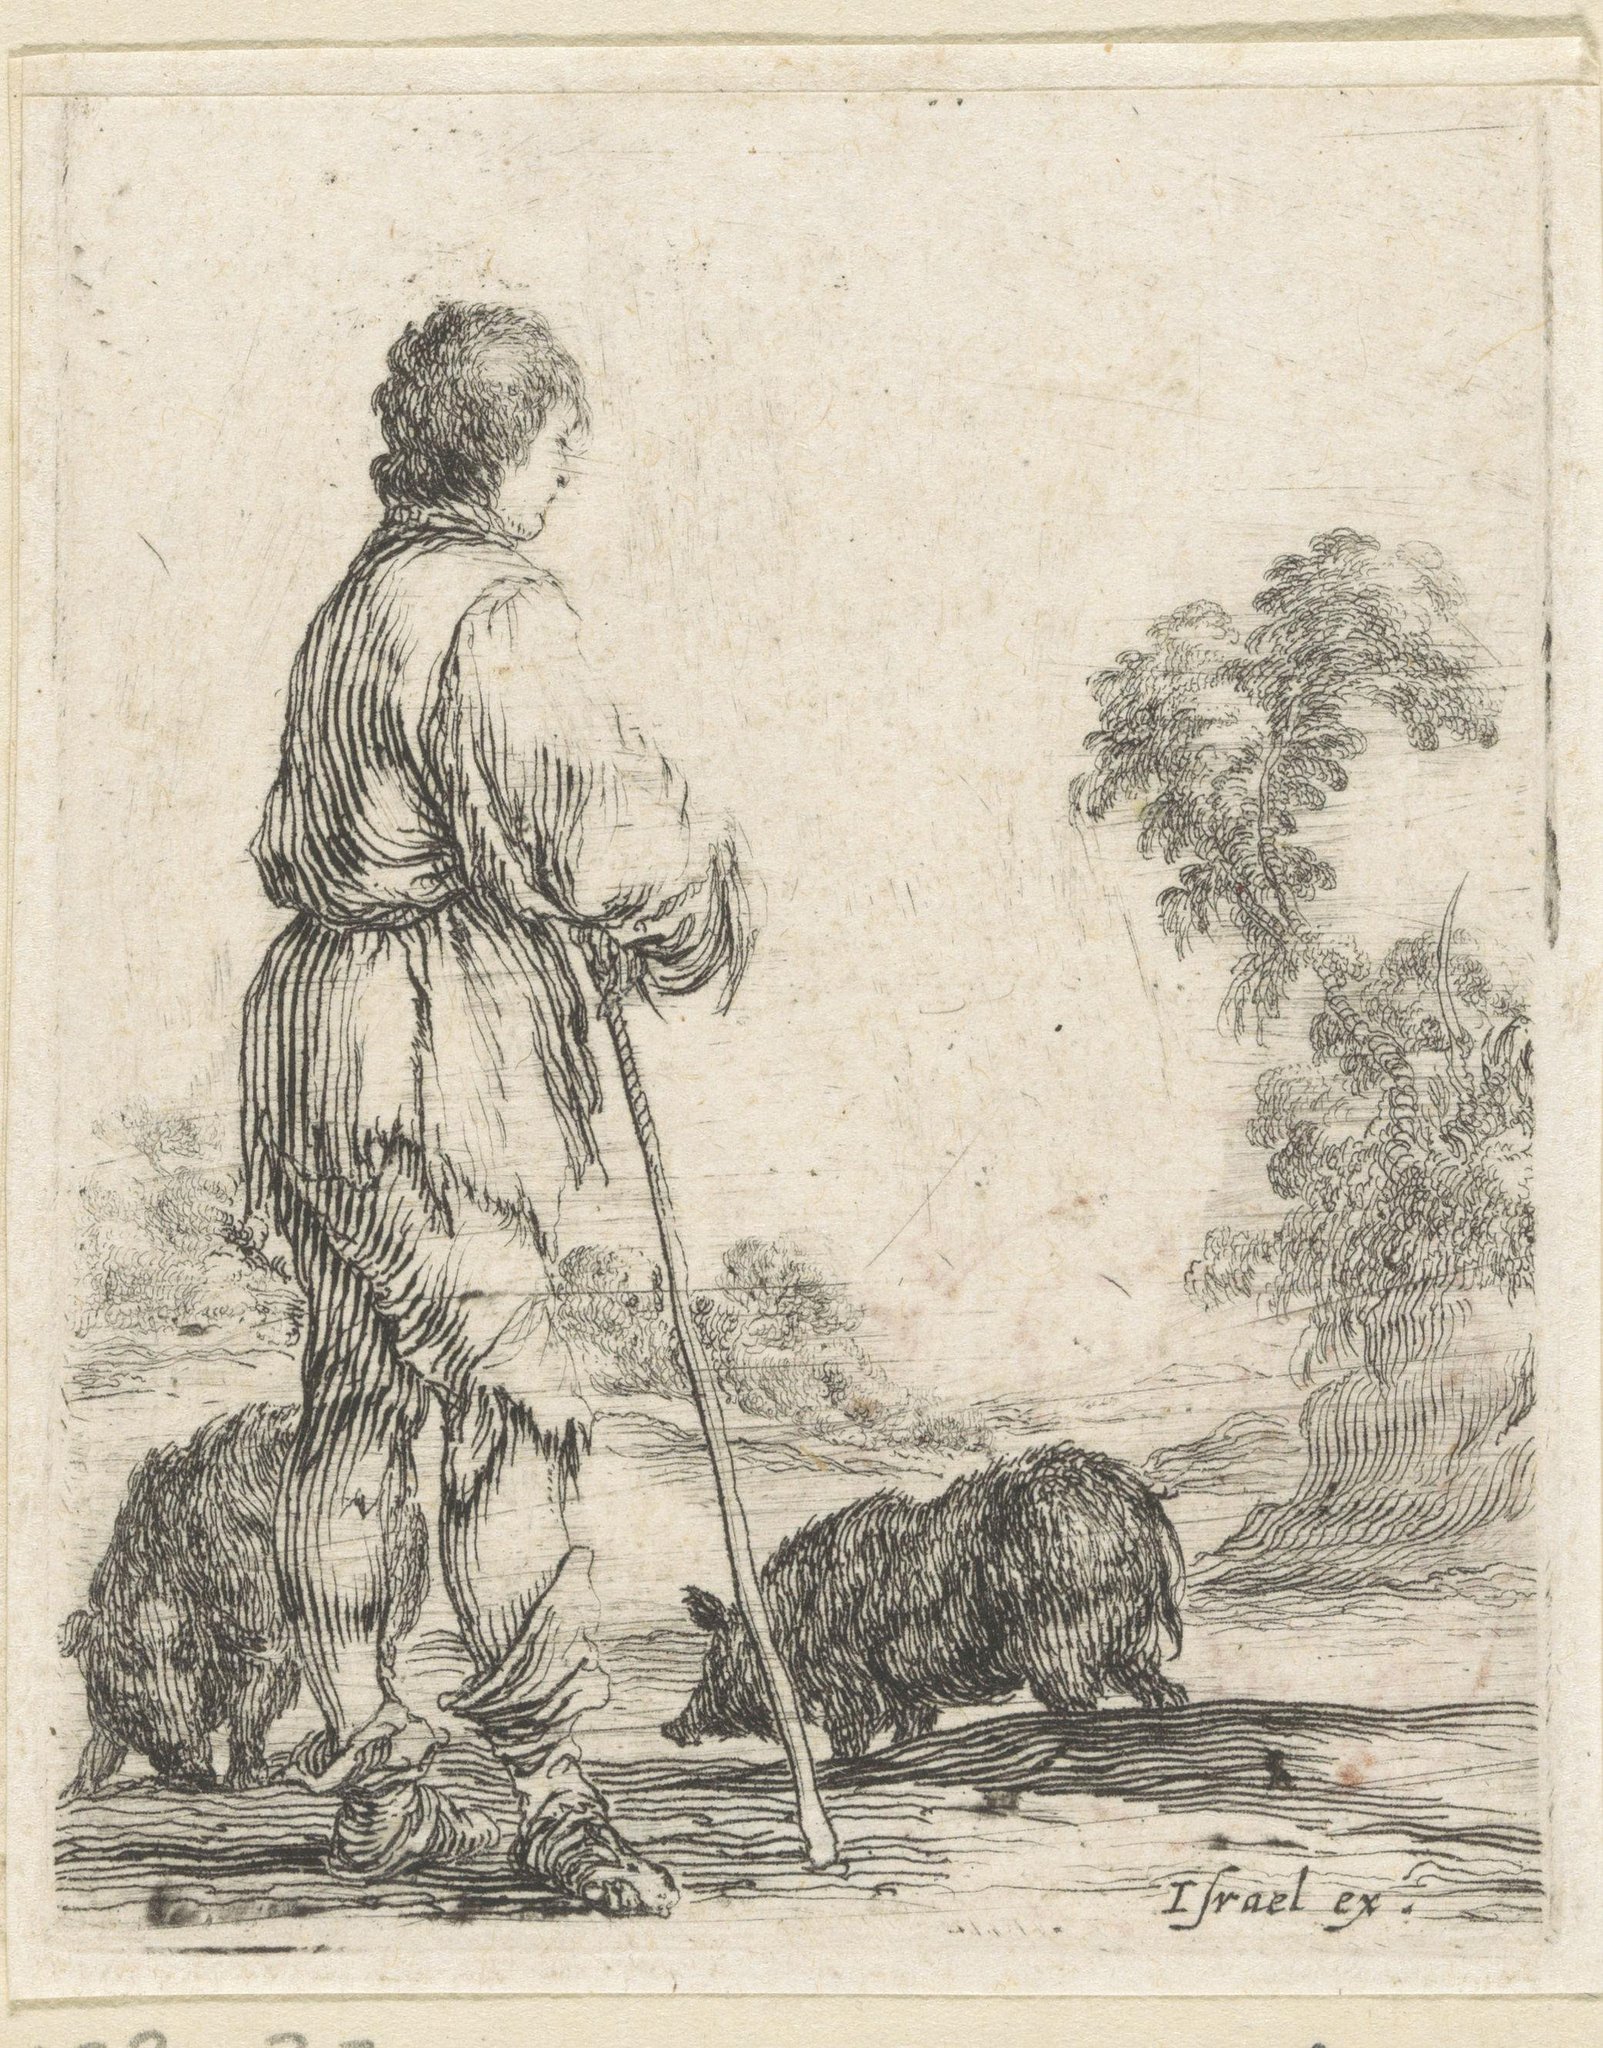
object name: print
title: Verloren Zoon de varkens hoedend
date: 1620-1664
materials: paper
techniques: etching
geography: paris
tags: the parable of the prodigal son (luke 15:11-32)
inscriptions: collector's mark: Lugt 240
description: Een jongeman, de Verloren Zoon, leunend op een stok in een landschap met twee varkens.